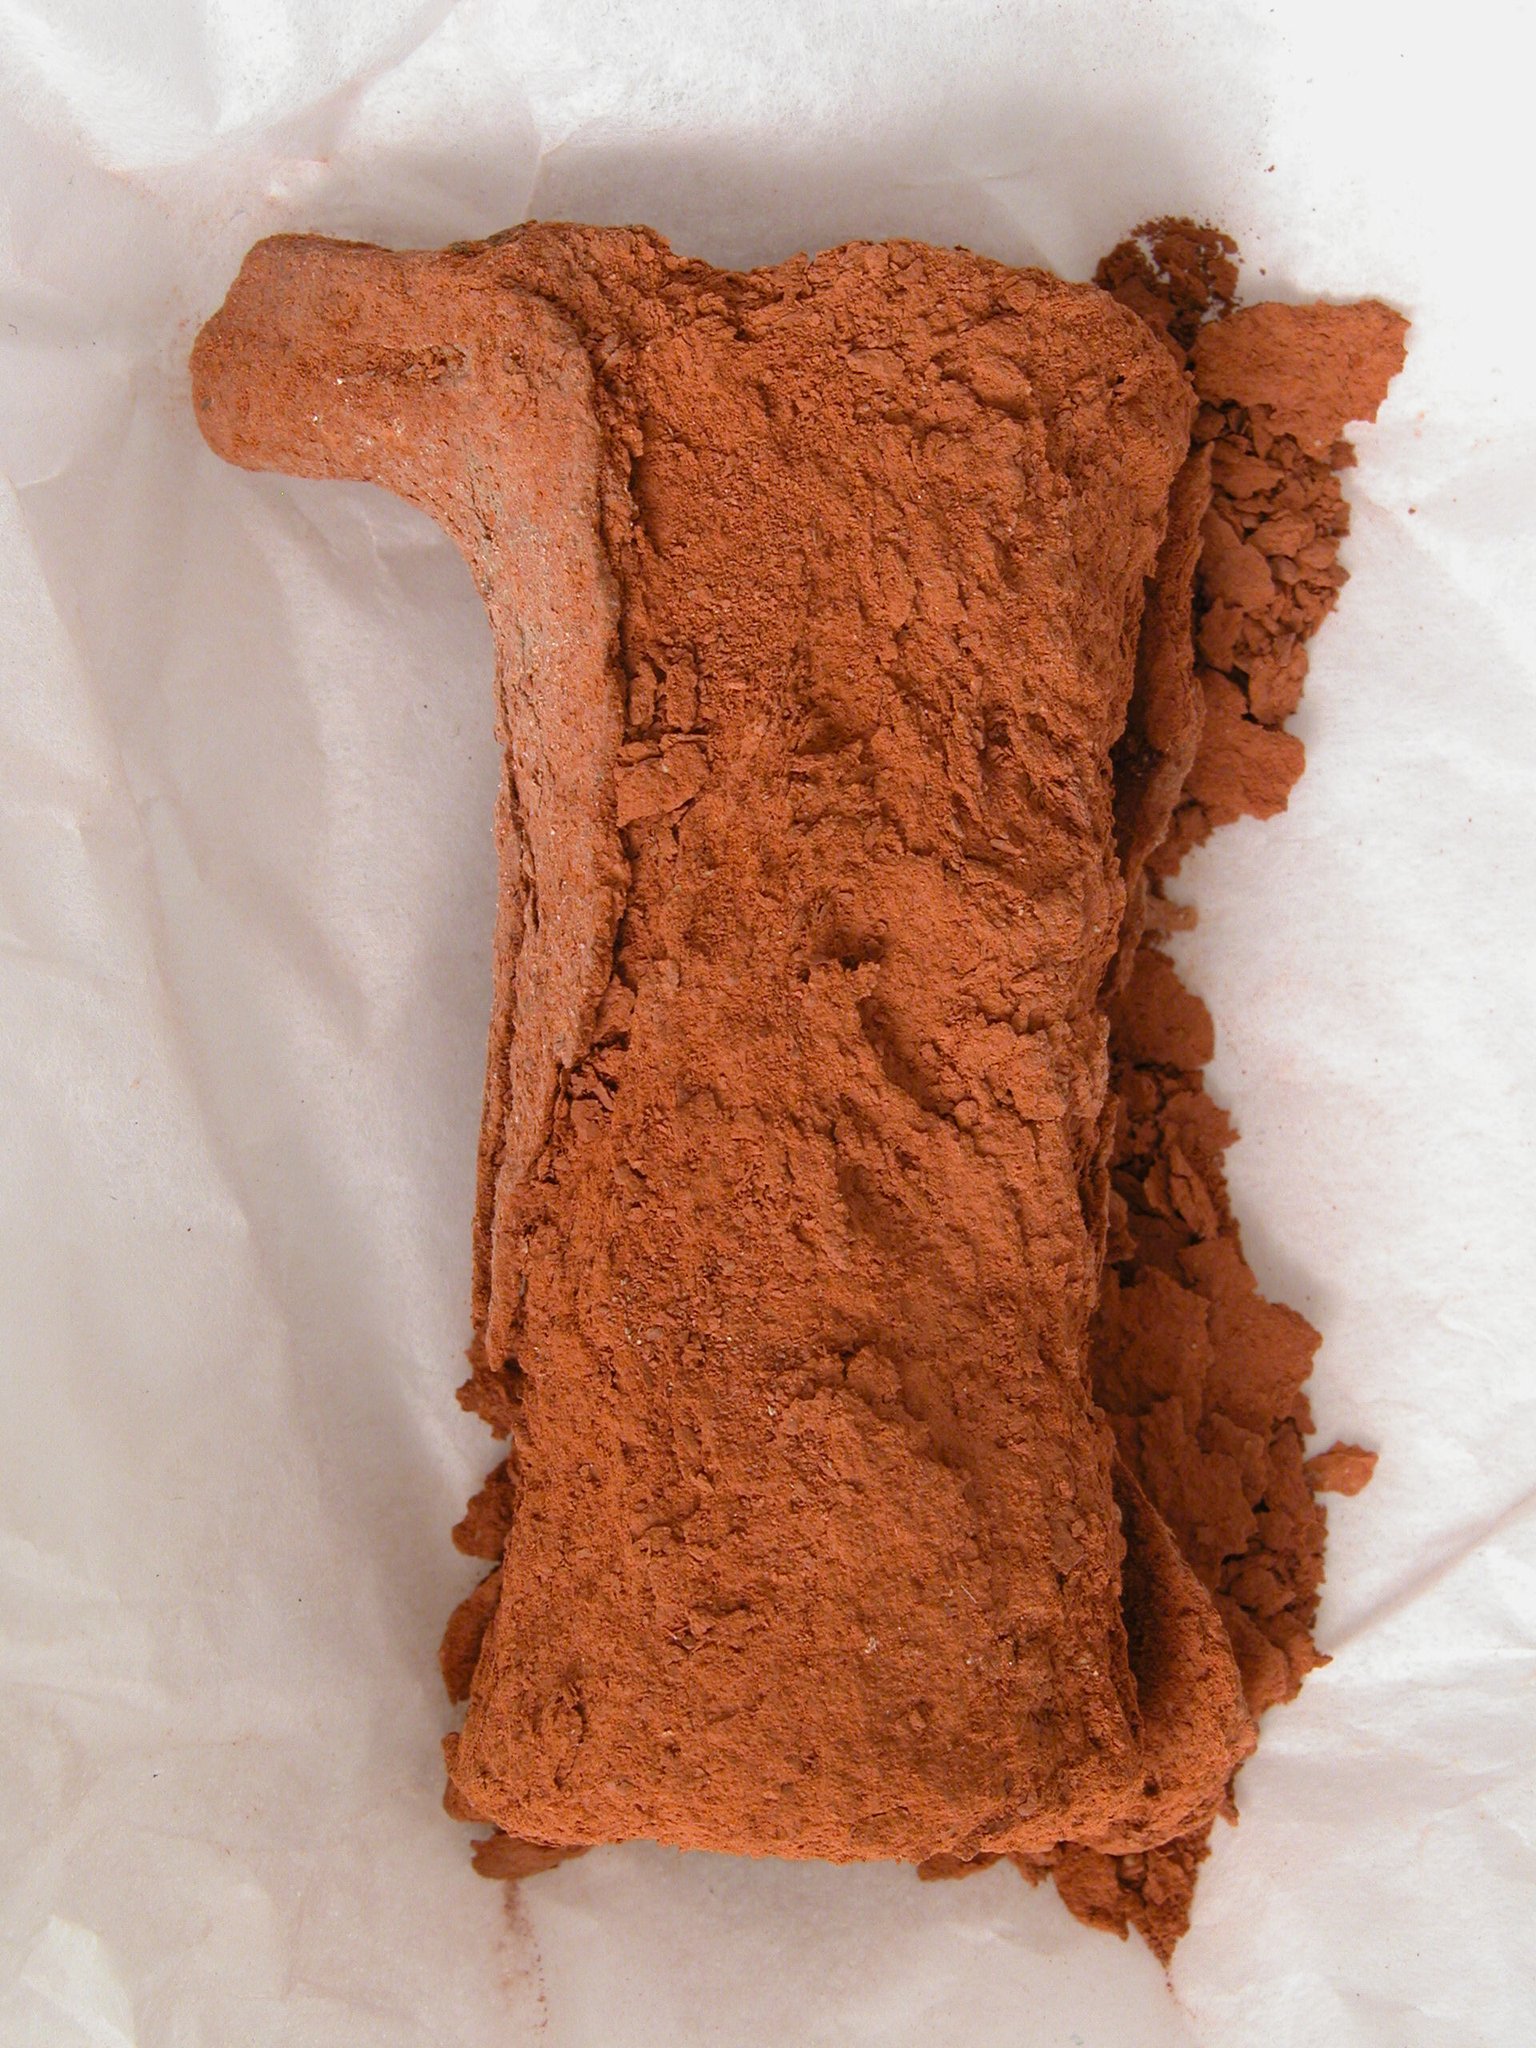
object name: statuette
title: Fragment of a Figure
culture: coptic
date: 301-700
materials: earthenware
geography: egypt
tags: human figures